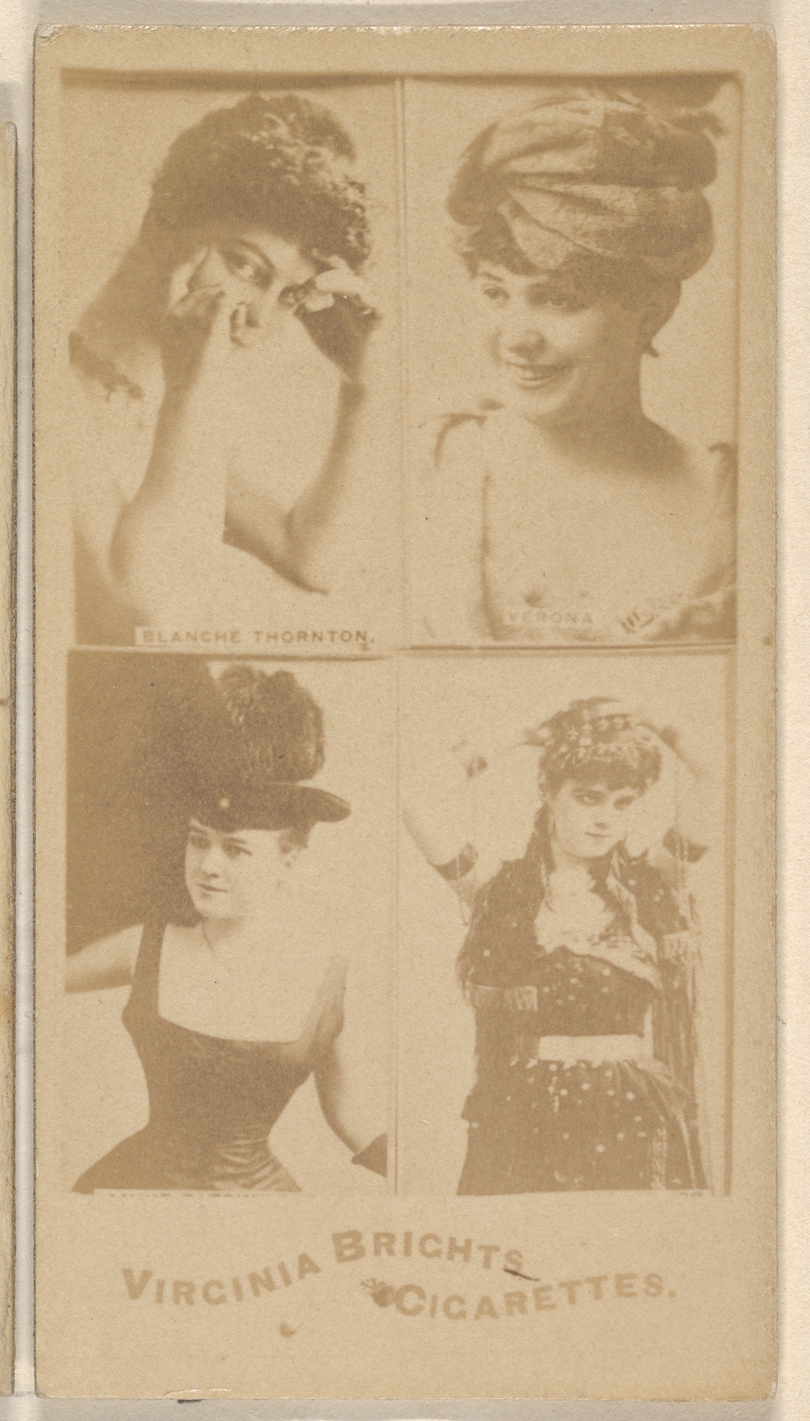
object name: photograph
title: Blanche Thornton/ Verona, from the Actors and Actresses series (N45, Type 4) for Virginia Brights Cigarettes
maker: allen & ginter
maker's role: publisher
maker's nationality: american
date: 1888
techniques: albumen silver print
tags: portraits,women,actresses